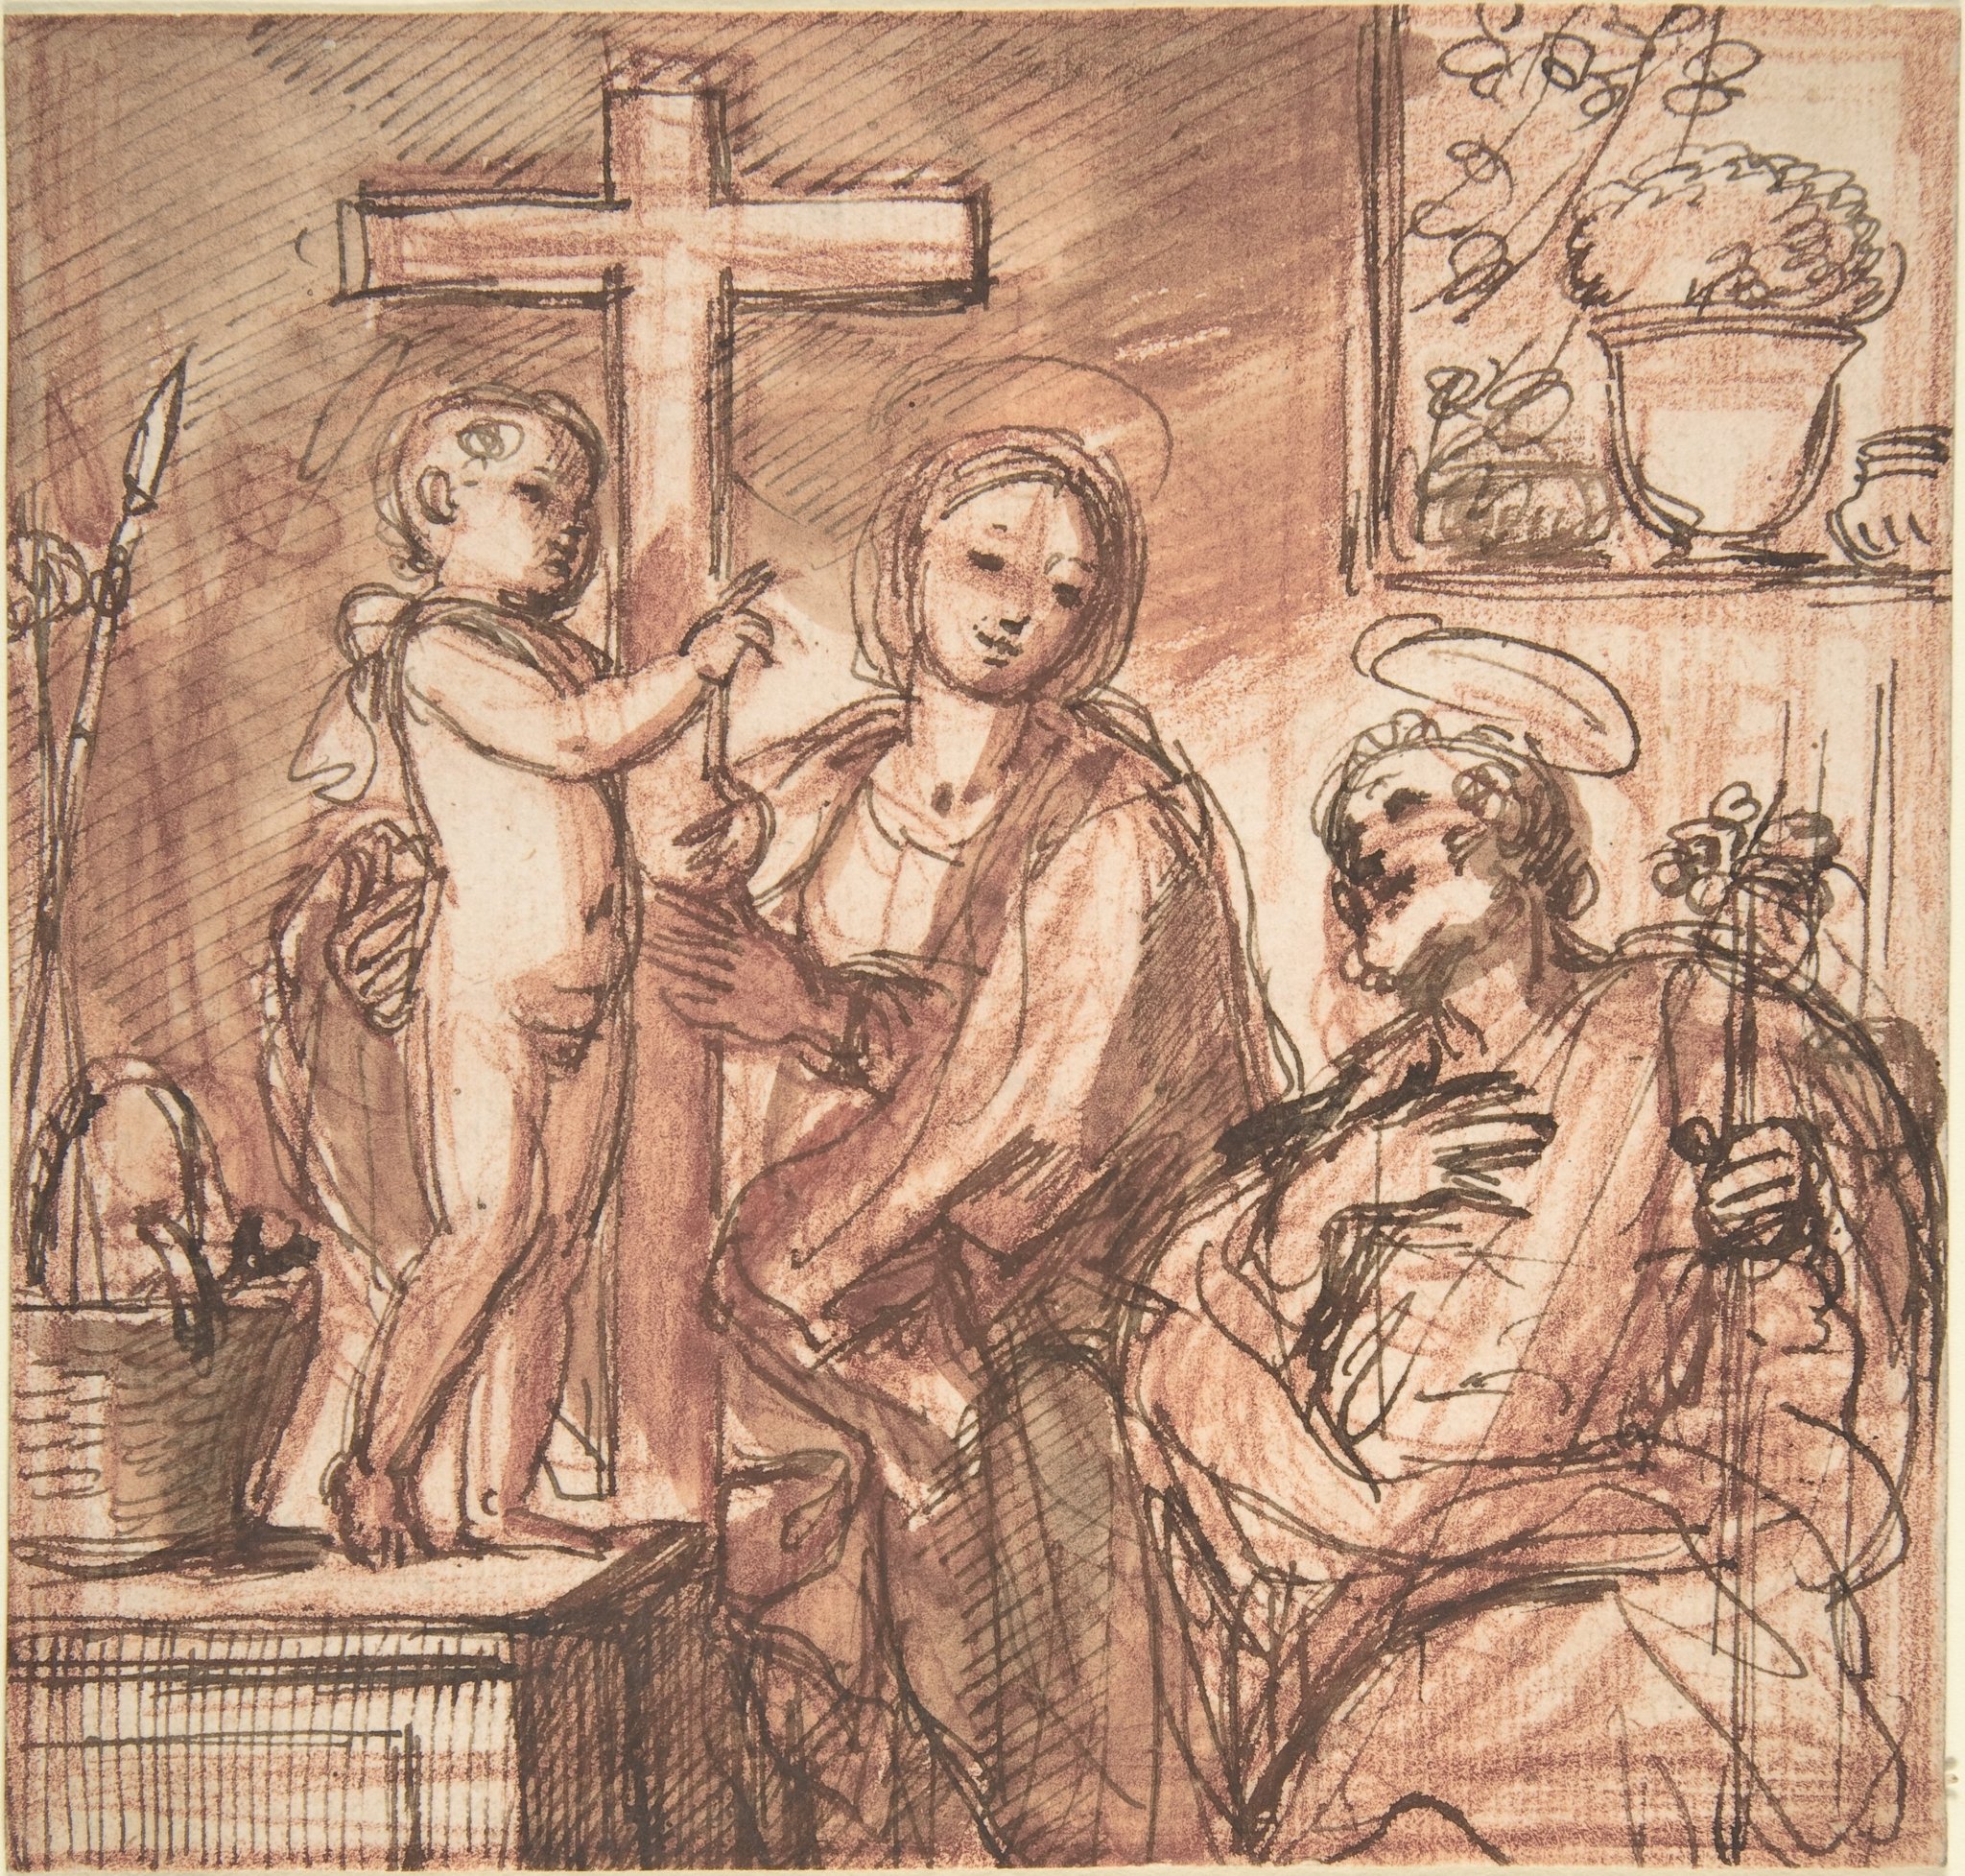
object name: drawing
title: Holy Family in an Interior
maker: anonymous, italian, roman-bolognese, 17th century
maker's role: artist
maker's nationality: italian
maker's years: 1600-1700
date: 1601-1700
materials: chalk, ink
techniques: brush, pen, wash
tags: holy family,cross